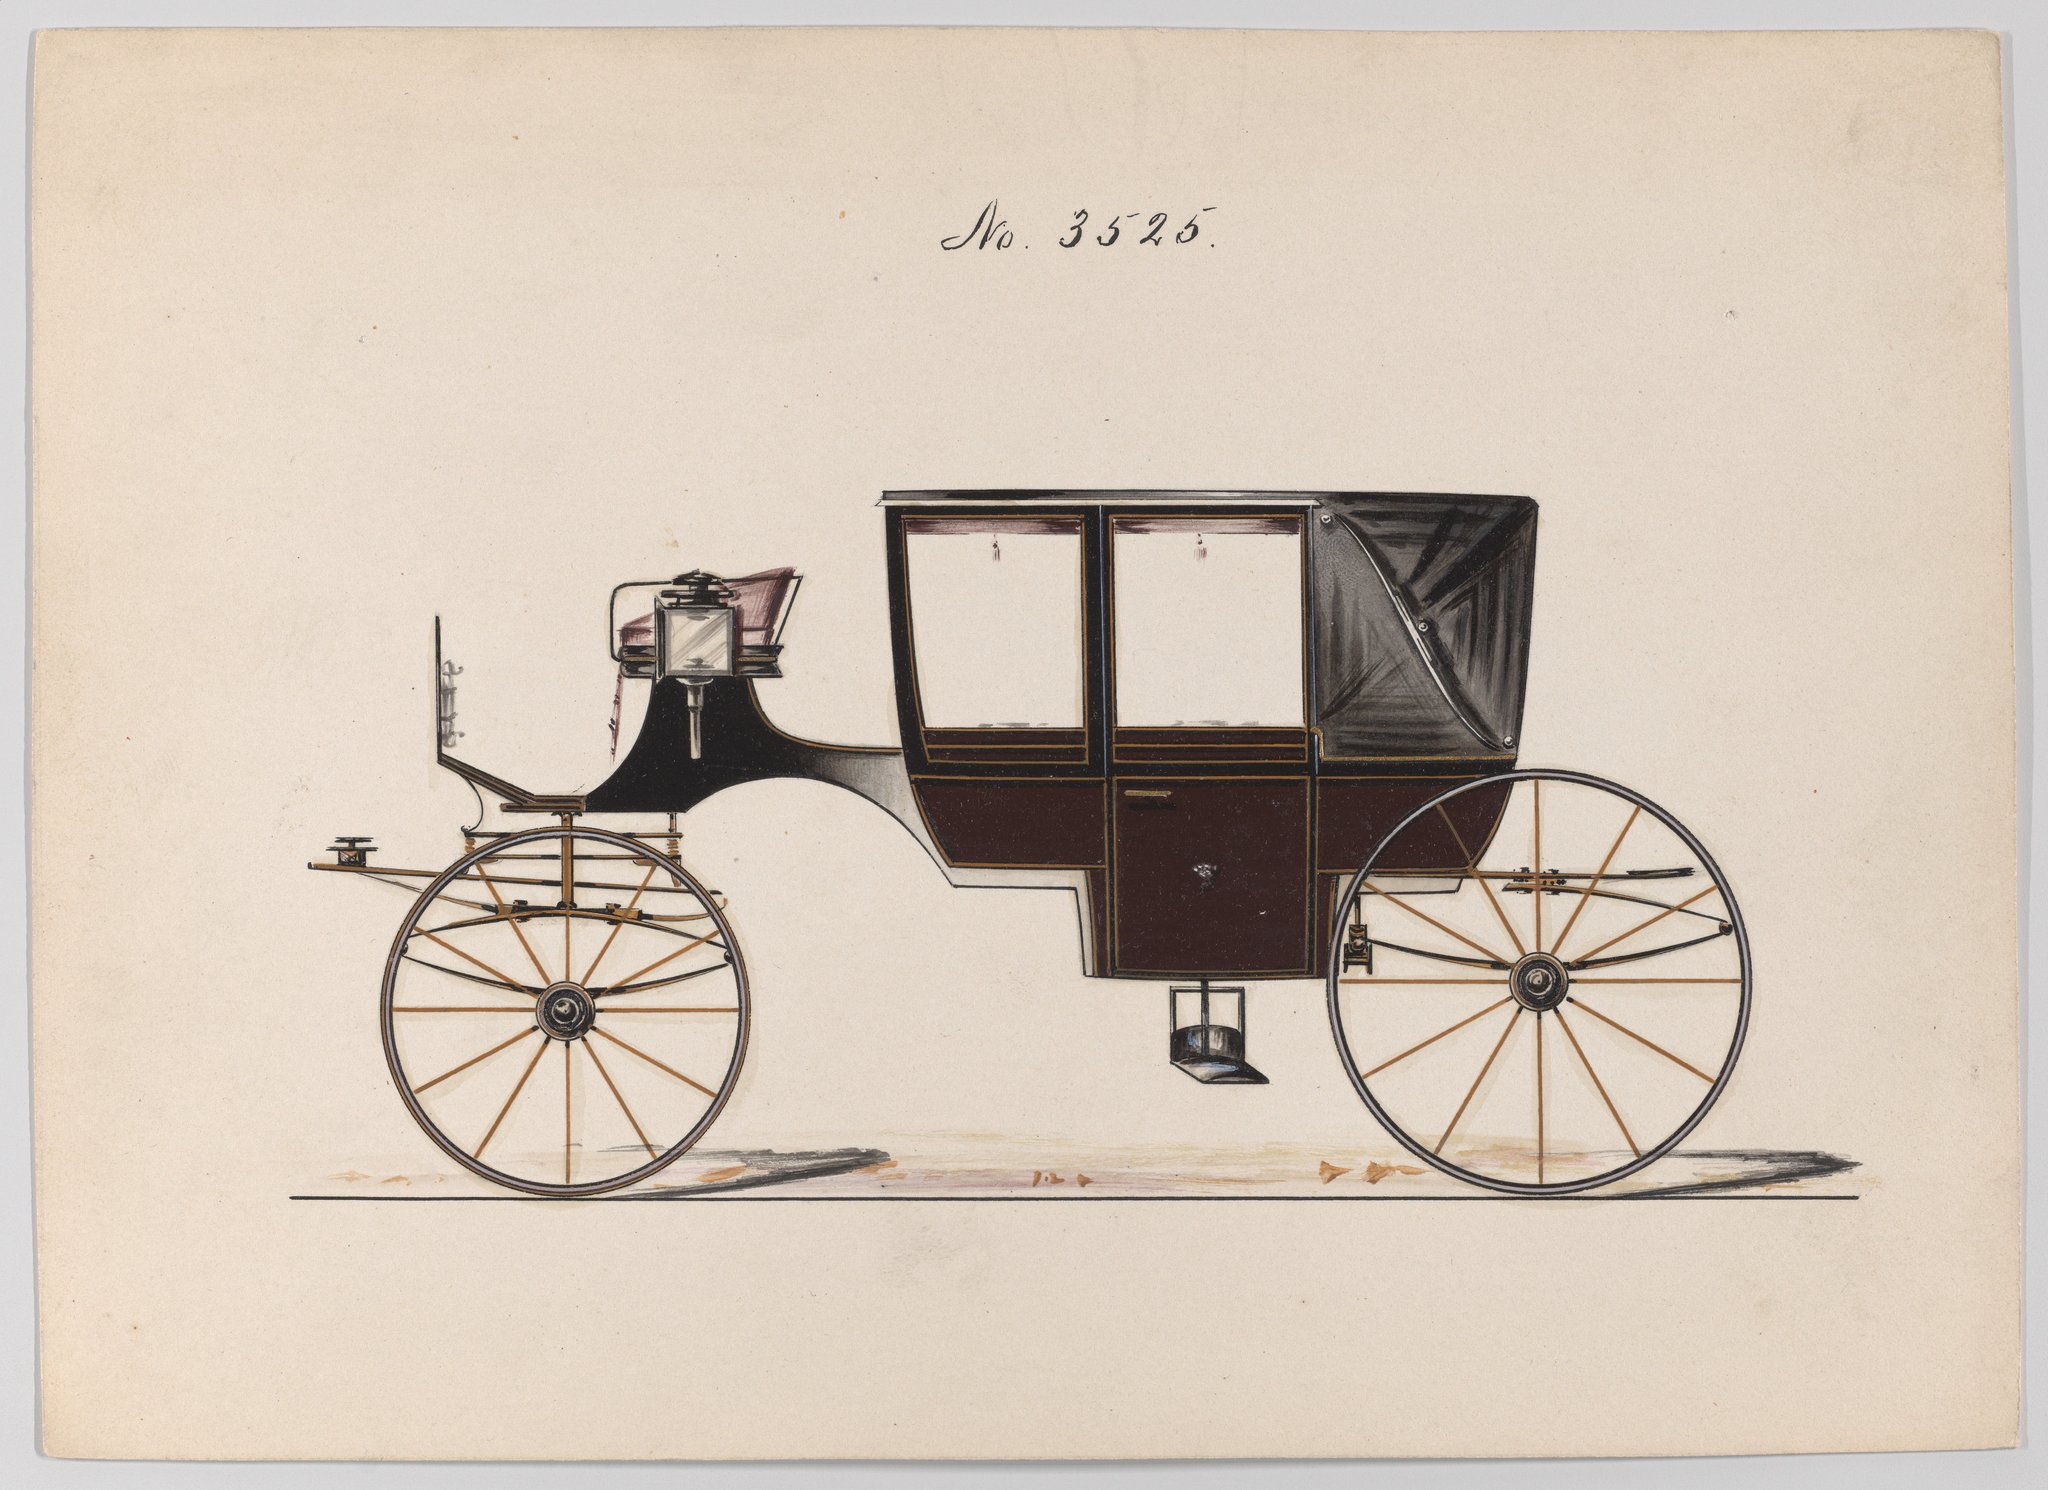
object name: drawing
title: Design for Landau, No. 3525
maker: brewster & co.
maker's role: manufacturer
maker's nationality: american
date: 1879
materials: gum arabic, ink, watercolor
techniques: pen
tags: carriages